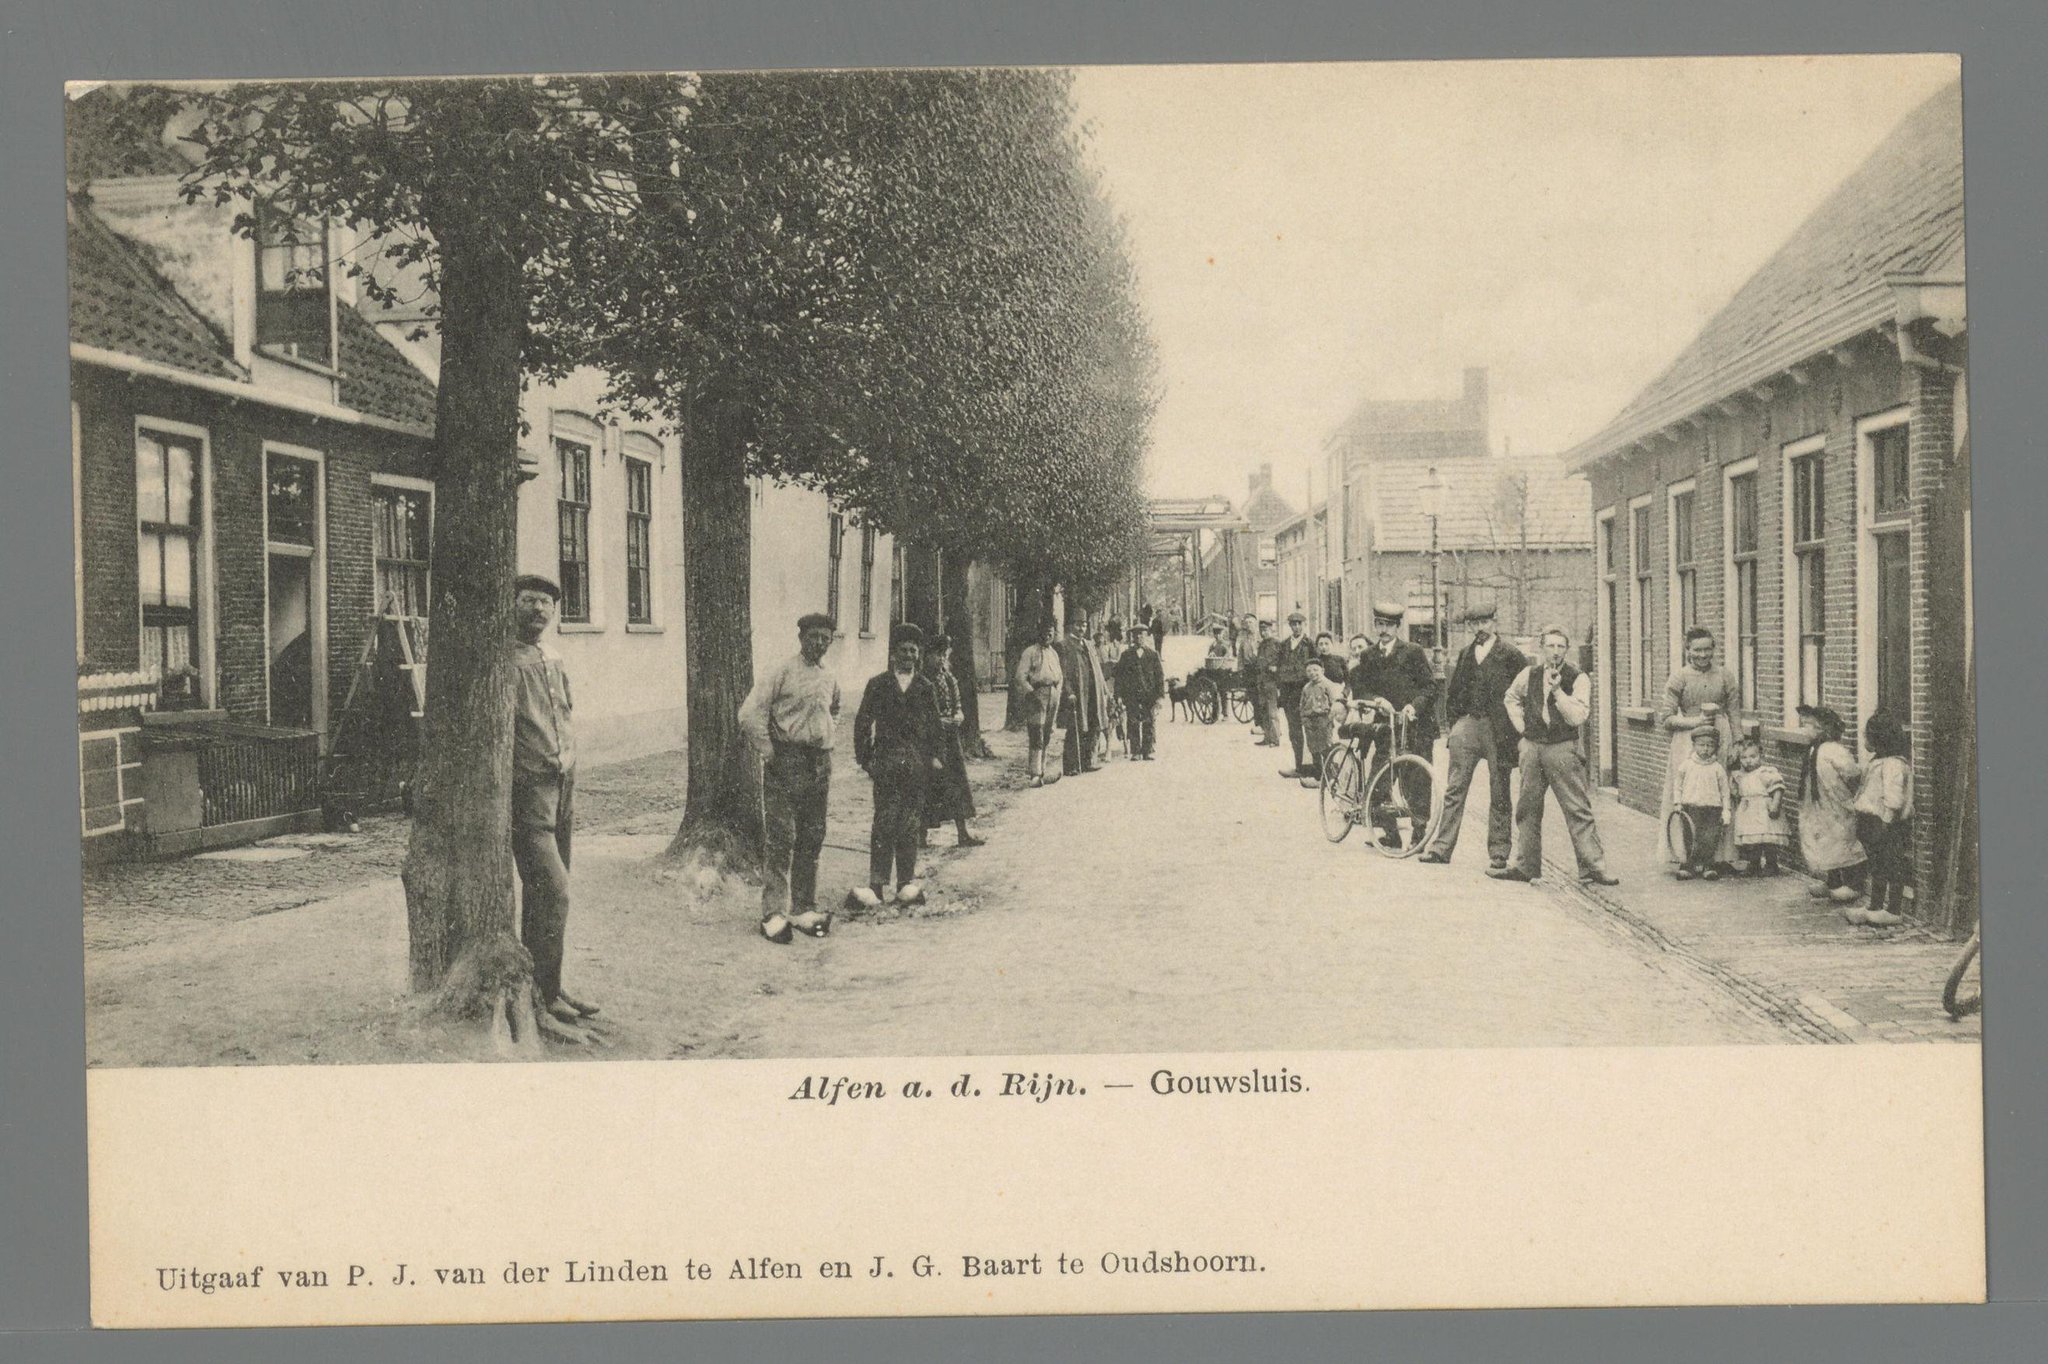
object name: ansichtkaart, prentbriefkaart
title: Alfen a.d. Rijn. - Gouwsluis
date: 1903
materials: cardboard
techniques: photograph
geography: alphen aan den rijn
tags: bridge in city across river, canal, etc., street